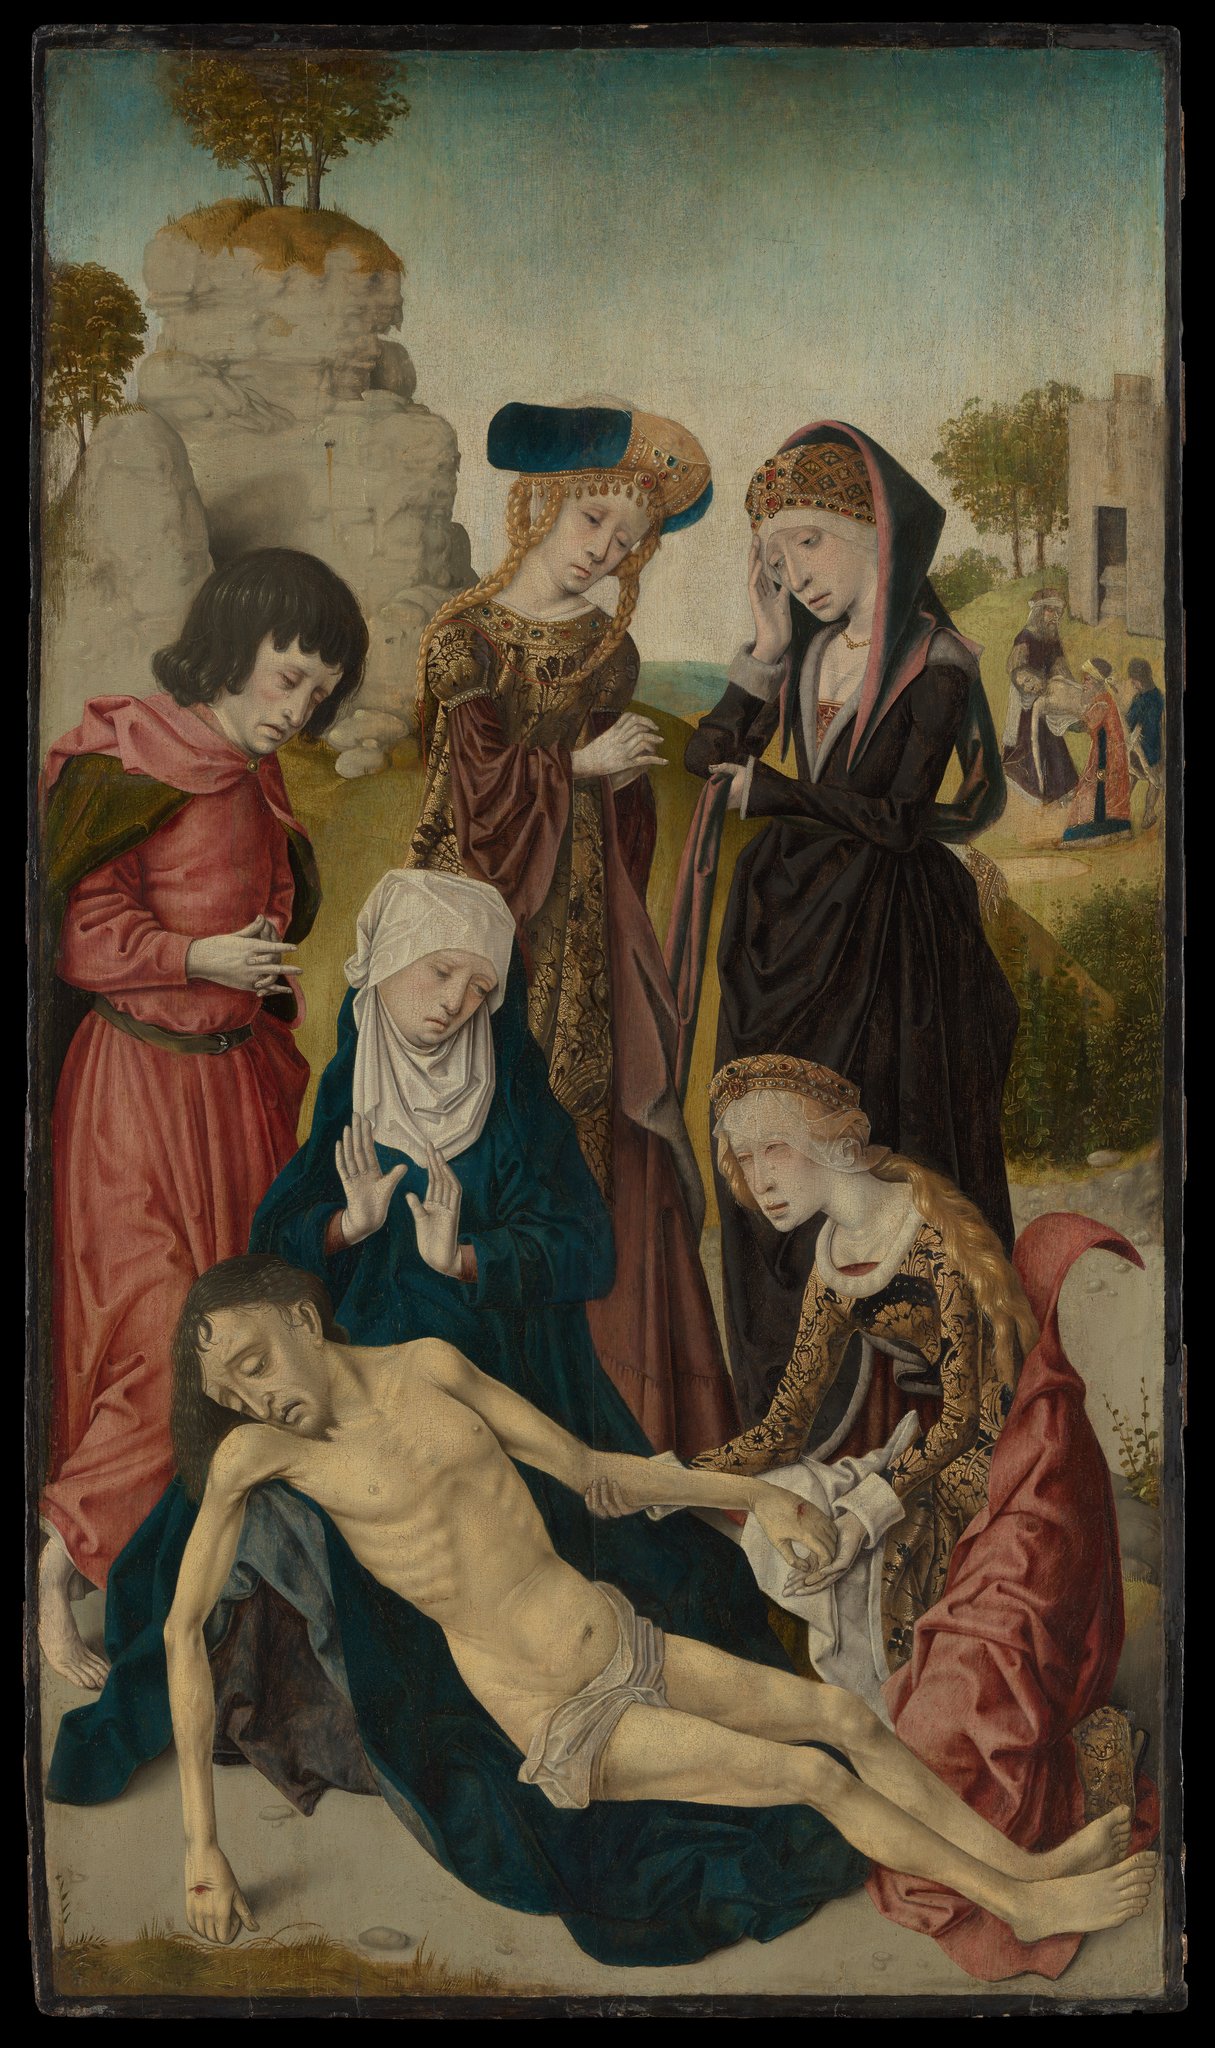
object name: painting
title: The Lamentation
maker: master of the virgin among virgins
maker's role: artist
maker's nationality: netherlandish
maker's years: 1460-1495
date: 1470-1499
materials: oil, wood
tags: sadness,suffering,christ,mary magdalene,saint john the evangelist,virgin mary,lamentation,death